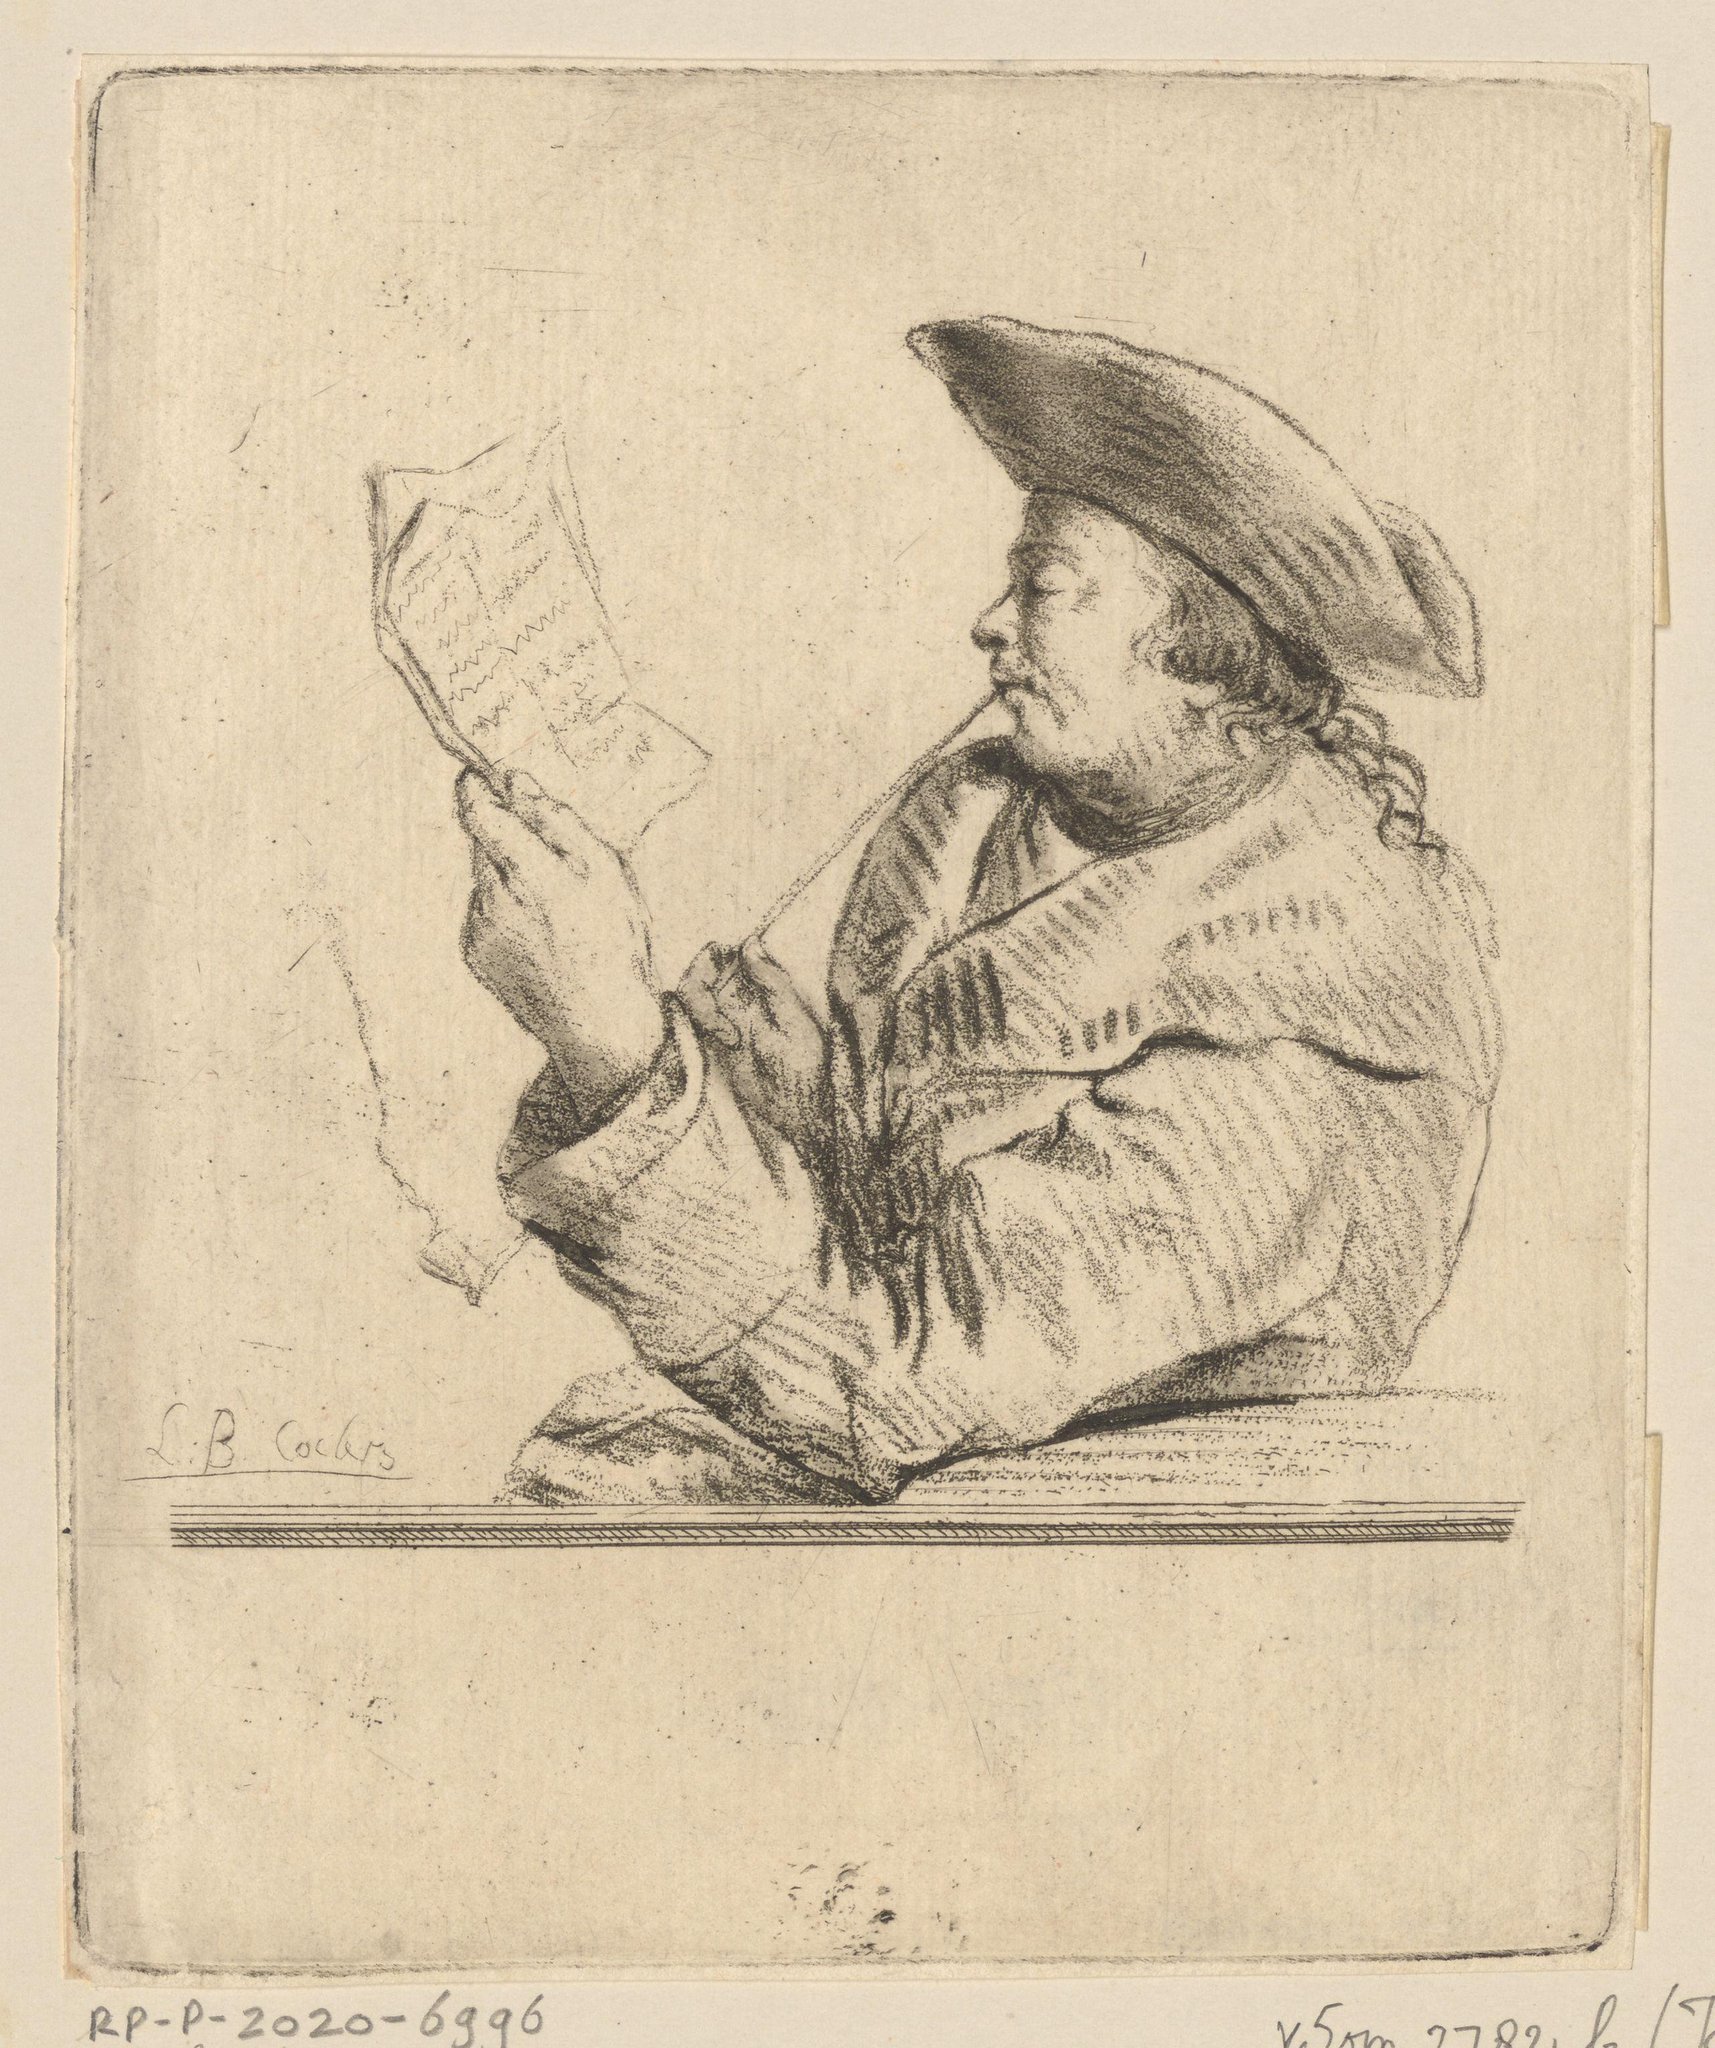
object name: print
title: Portret van Johannes Janson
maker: jean baptiste coclers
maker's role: print maker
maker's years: 1740-1817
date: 1751-1817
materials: paper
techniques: printmaking, etching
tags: leiden, draughtsman, johannes janson, reading, historical persons, pipe ~ tobacco, portrait, self-portrait of painter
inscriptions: collector's mark: Lugt 964